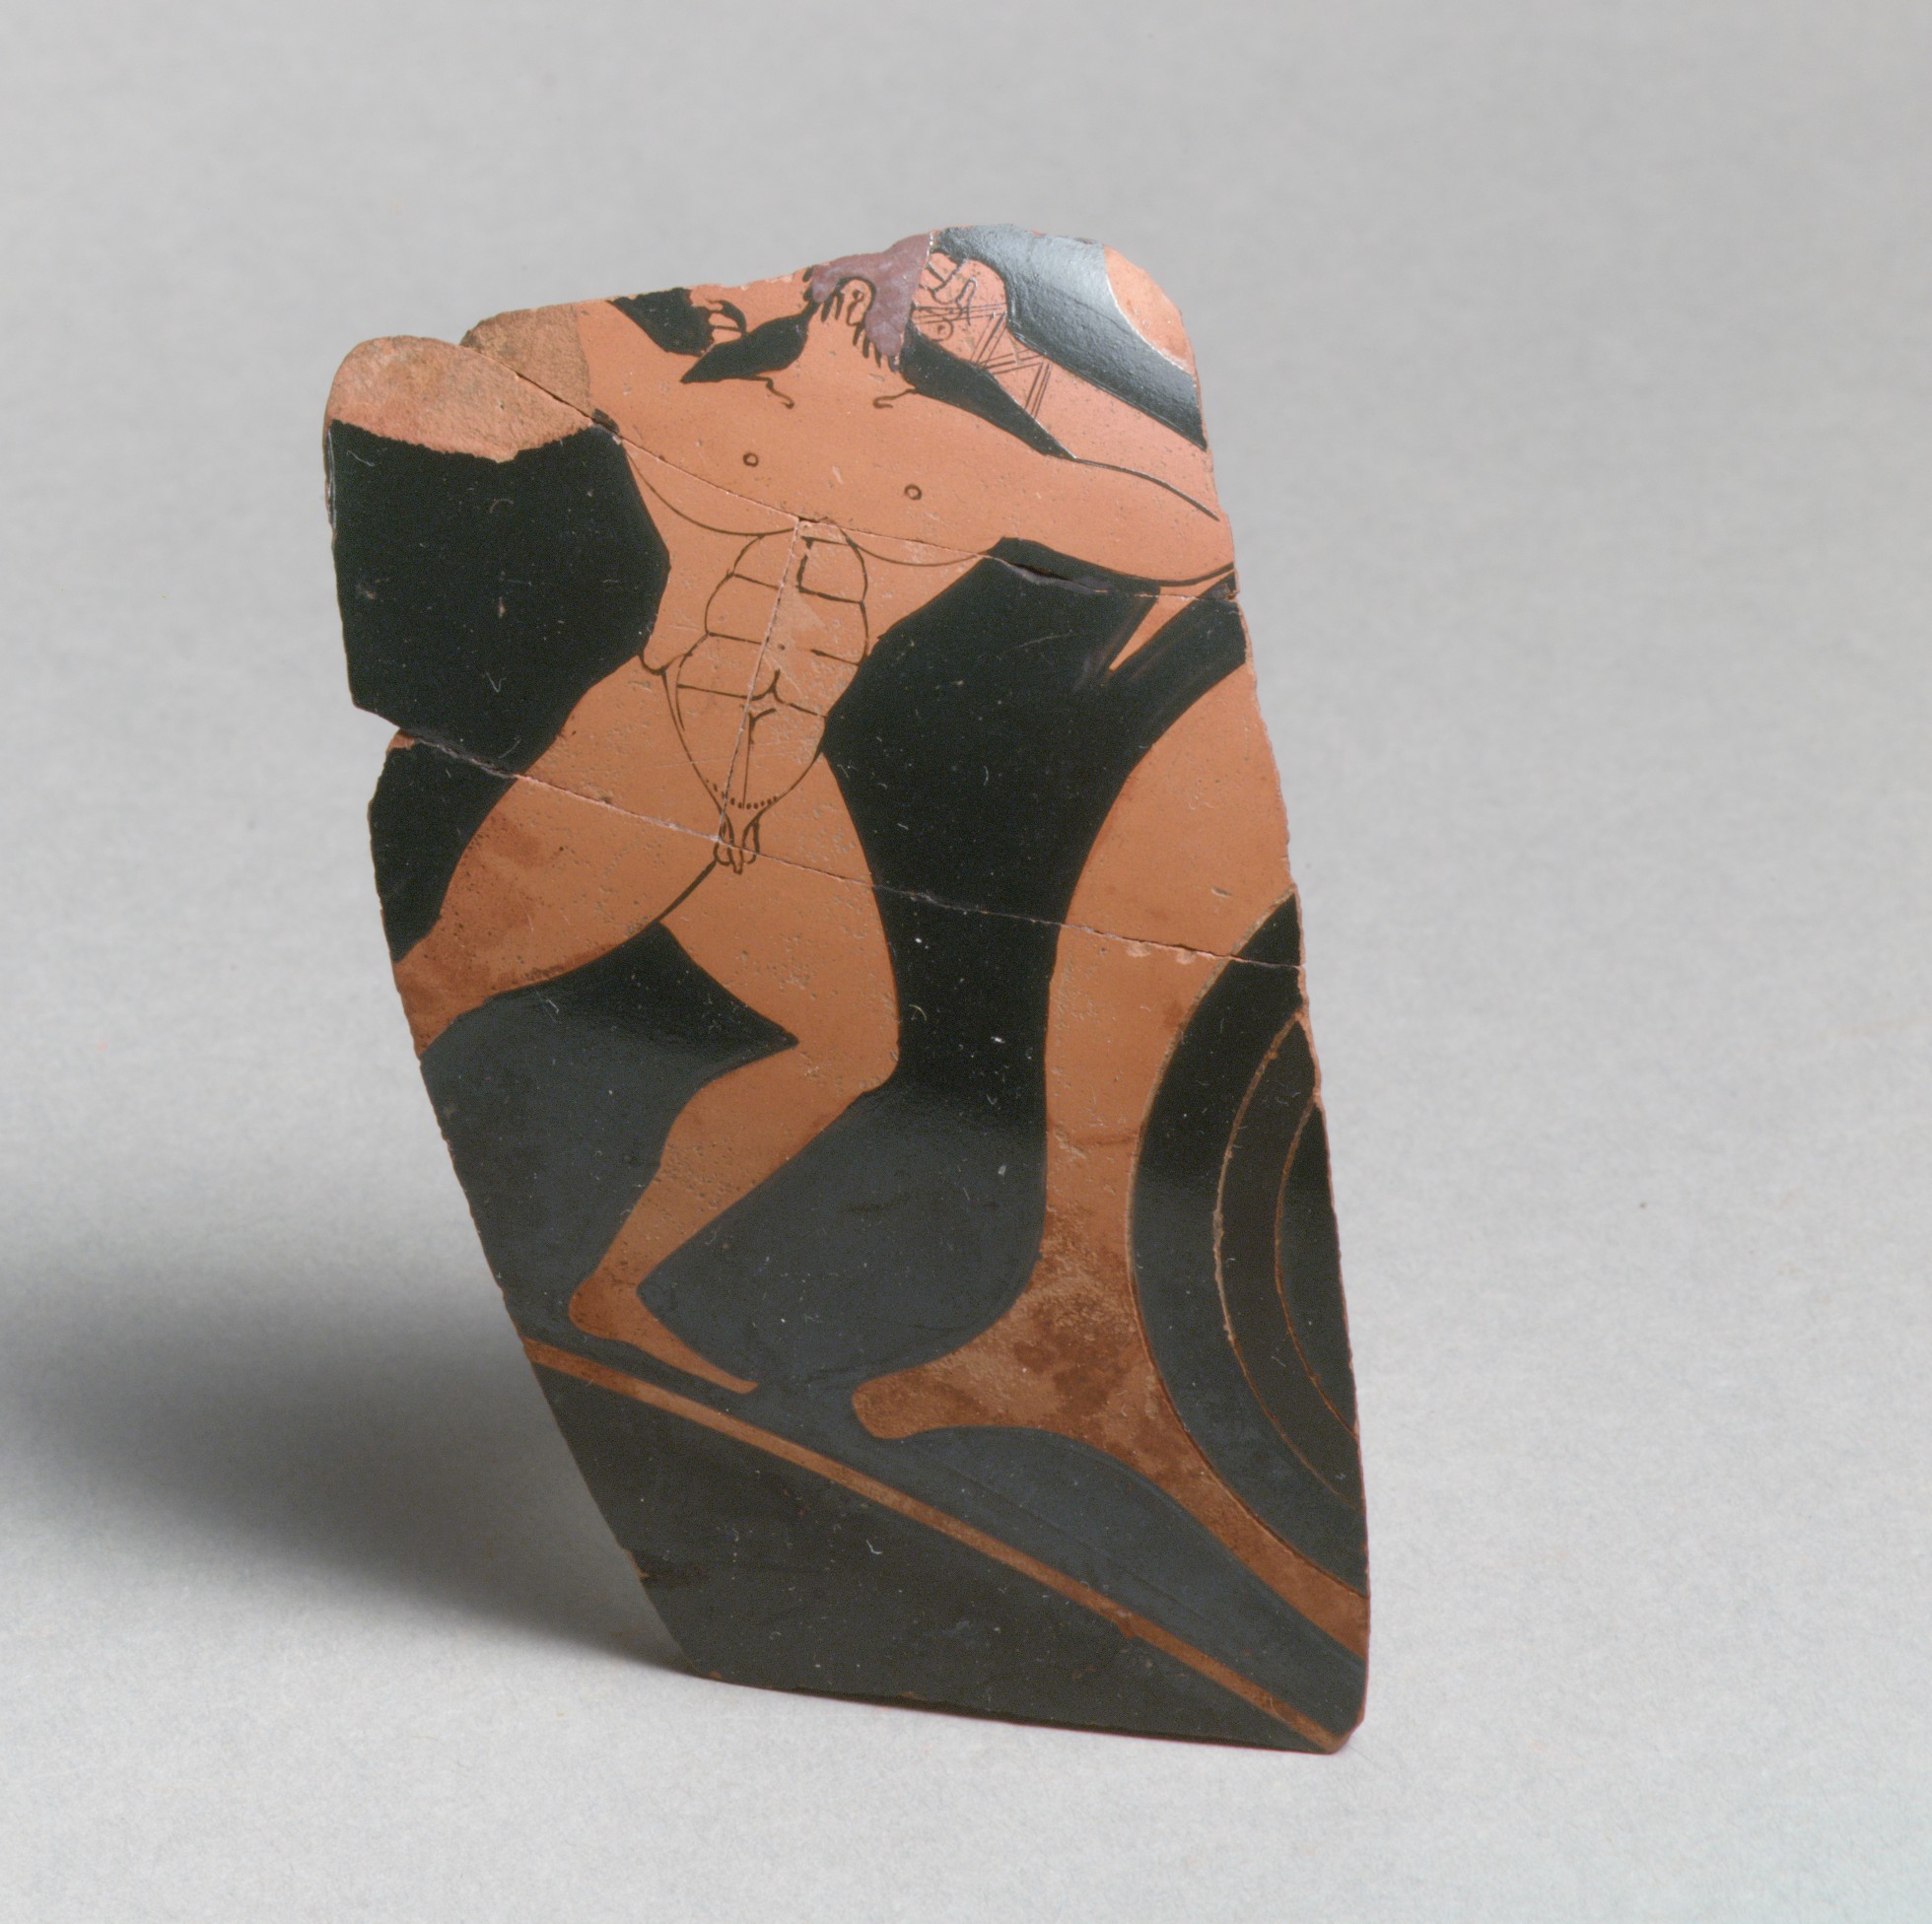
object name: kylix, eye cup fragment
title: Fragment of a terracotta kylix: eye-cup (drinking cup)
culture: greek, attic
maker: hischylos painter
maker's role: artist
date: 520 BCE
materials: terracotta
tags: male nudes